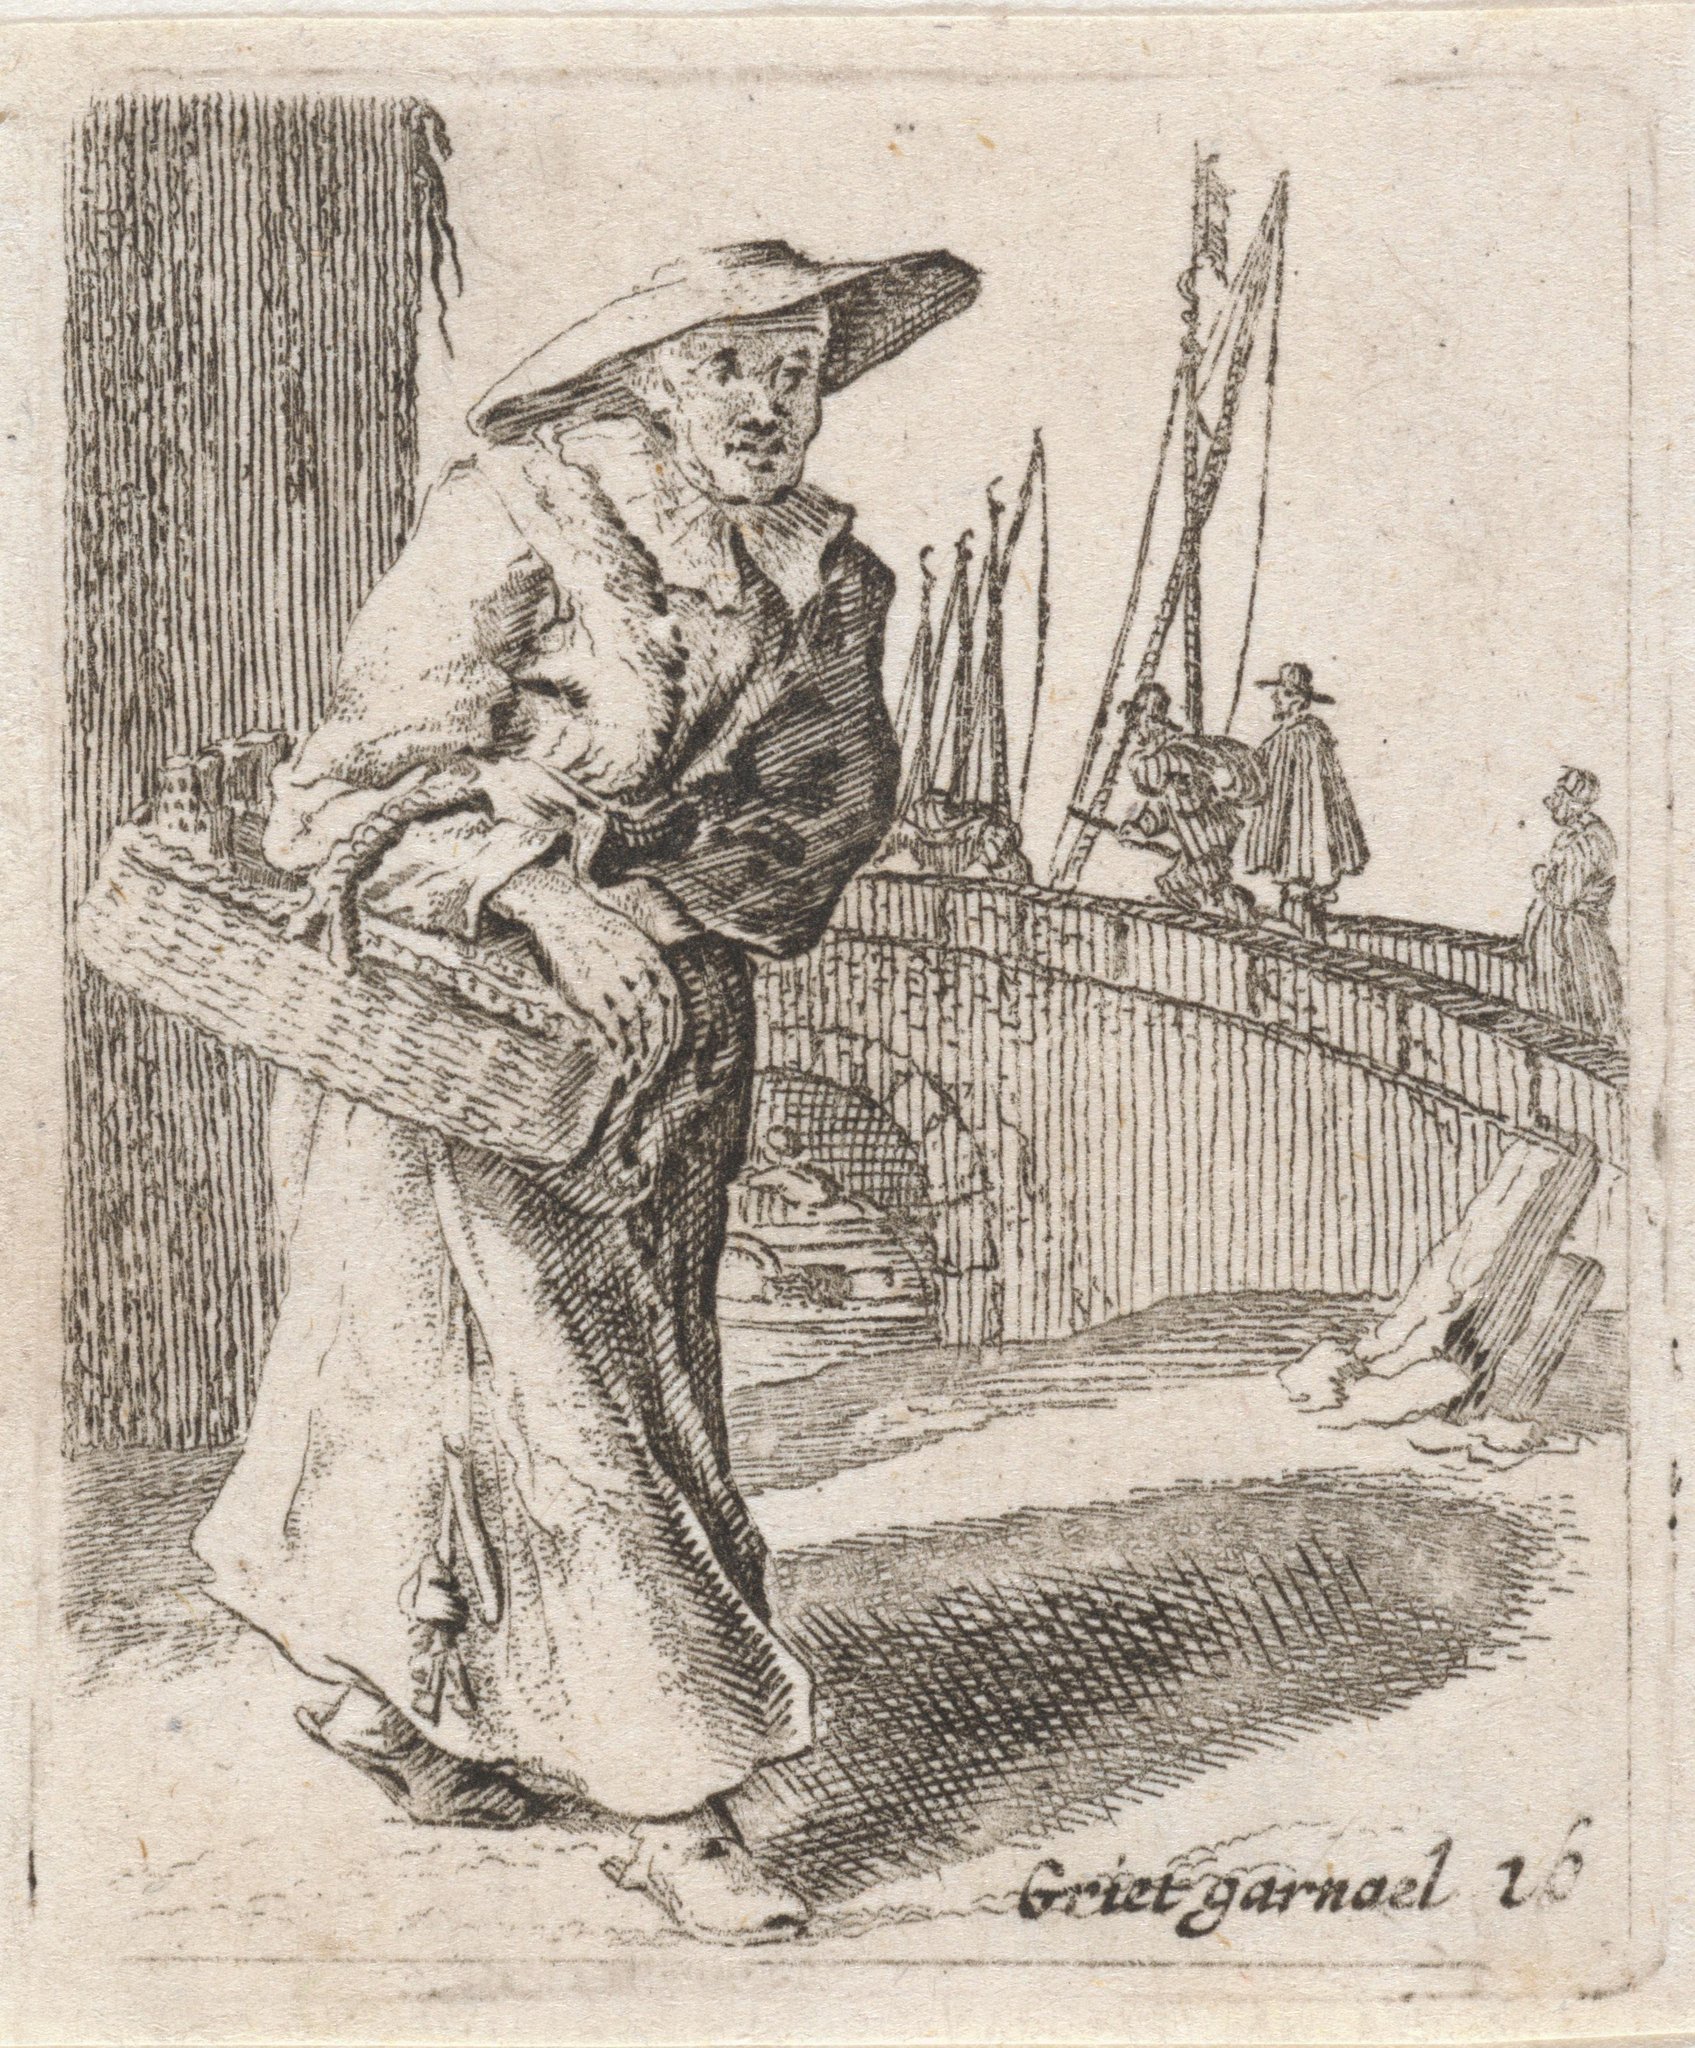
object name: print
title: Genretaferelen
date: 1630-1706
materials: paper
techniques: engraving, etching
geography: netherlands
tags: sailing-ship, sailing-boat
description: Een vrouw (Griet garnael) met een mand om haar arm loopt naar rechts. Op de achtergrond een brug met enkele figuren en scheepsmasten. De prent maakt deel uit van een serie van 32 prenten met genretaferelen.